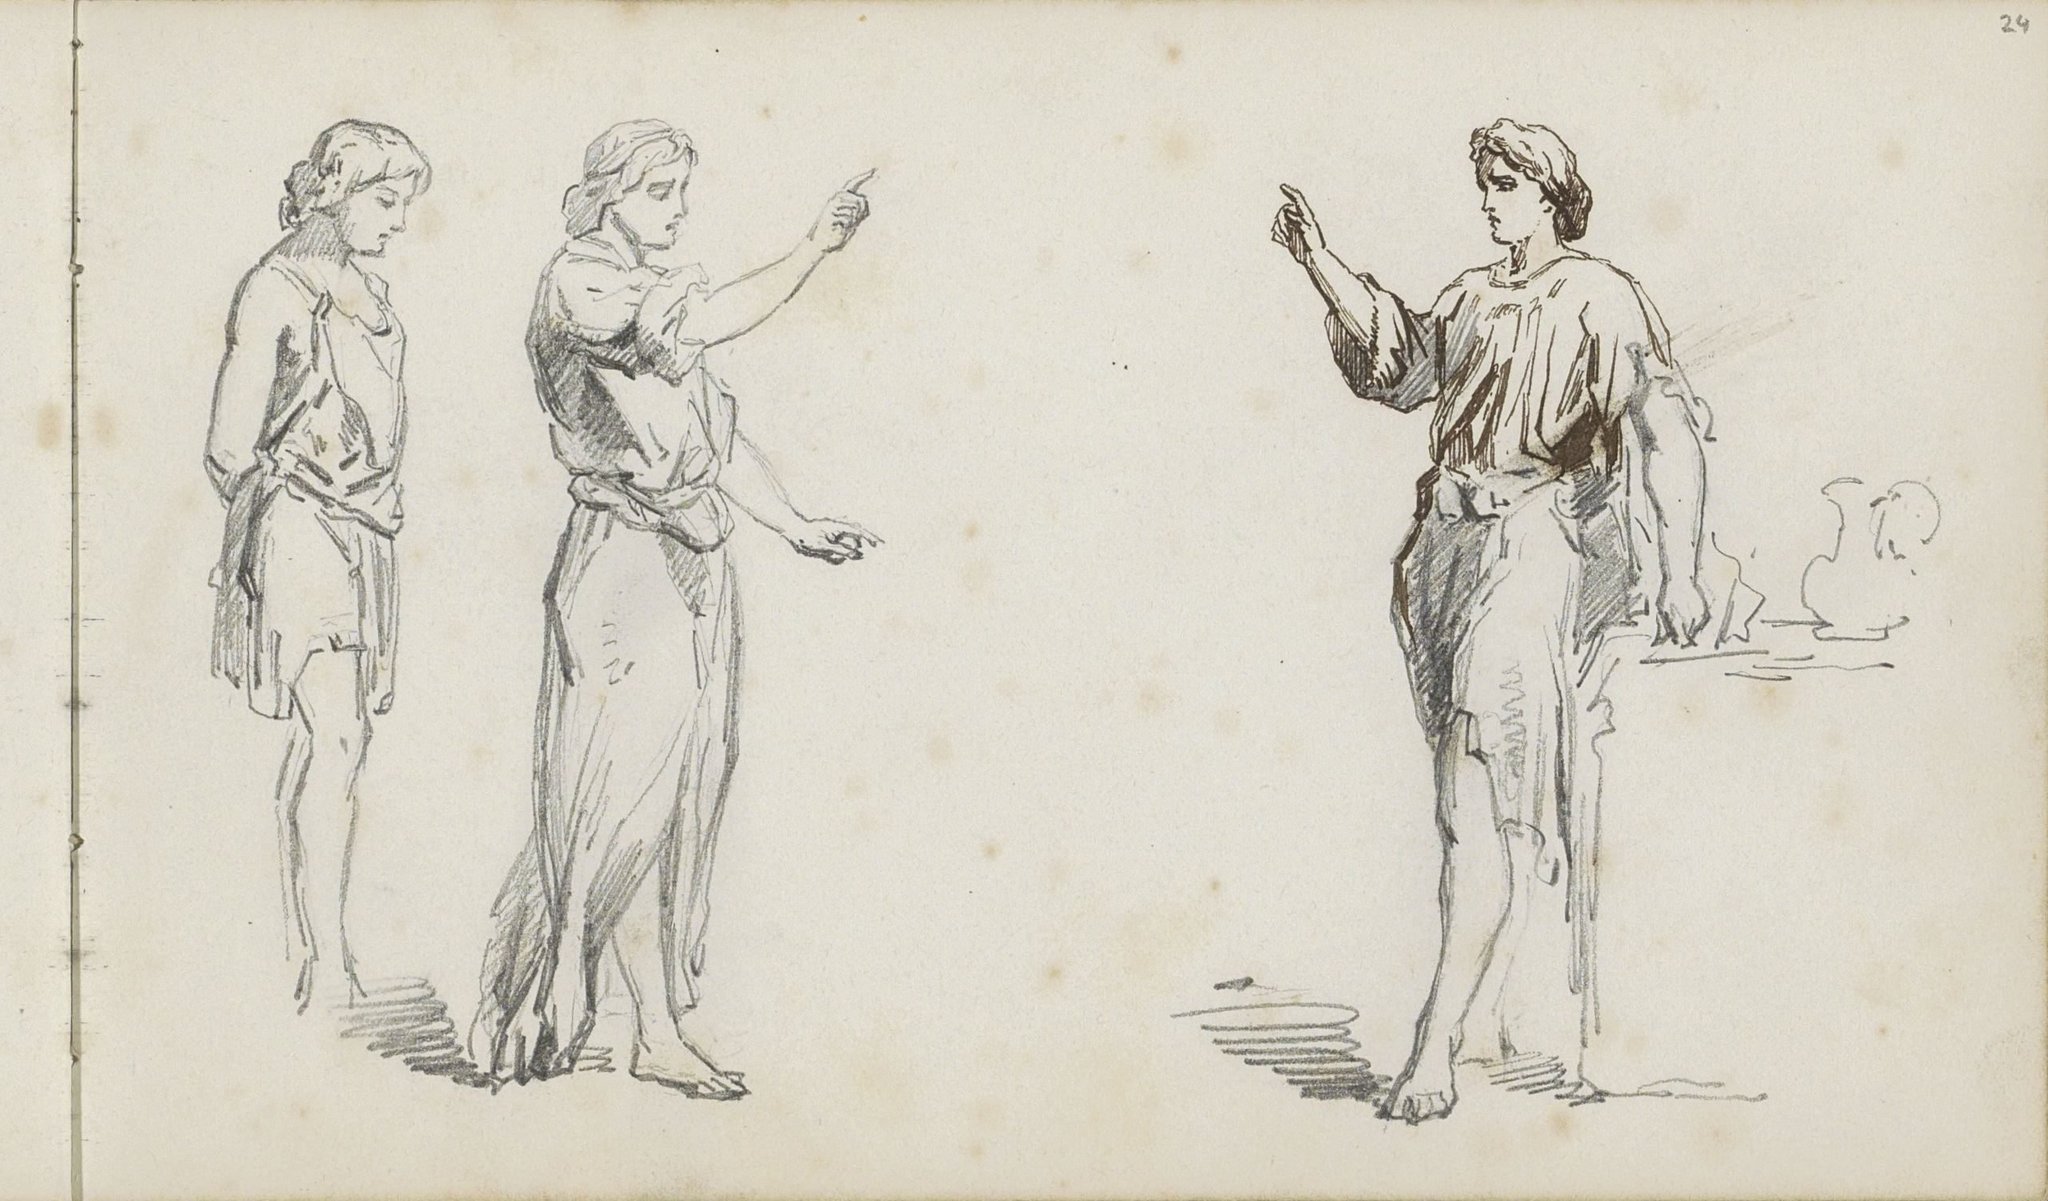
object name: sketchbook leaf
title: Vrouwen in historisch kostuum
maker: charles rochussen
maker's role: draughtsman, painter, print maker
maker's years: 1814-1894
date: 1840-1860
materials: ink, paper, pencil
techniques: pen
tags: arm raised upward, historical costume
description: Studie van een staande vrouw in een tuniek en twee vrouwen met opgeheven hand. Blad 24 recto uit een schetsboek met 38 bladen.